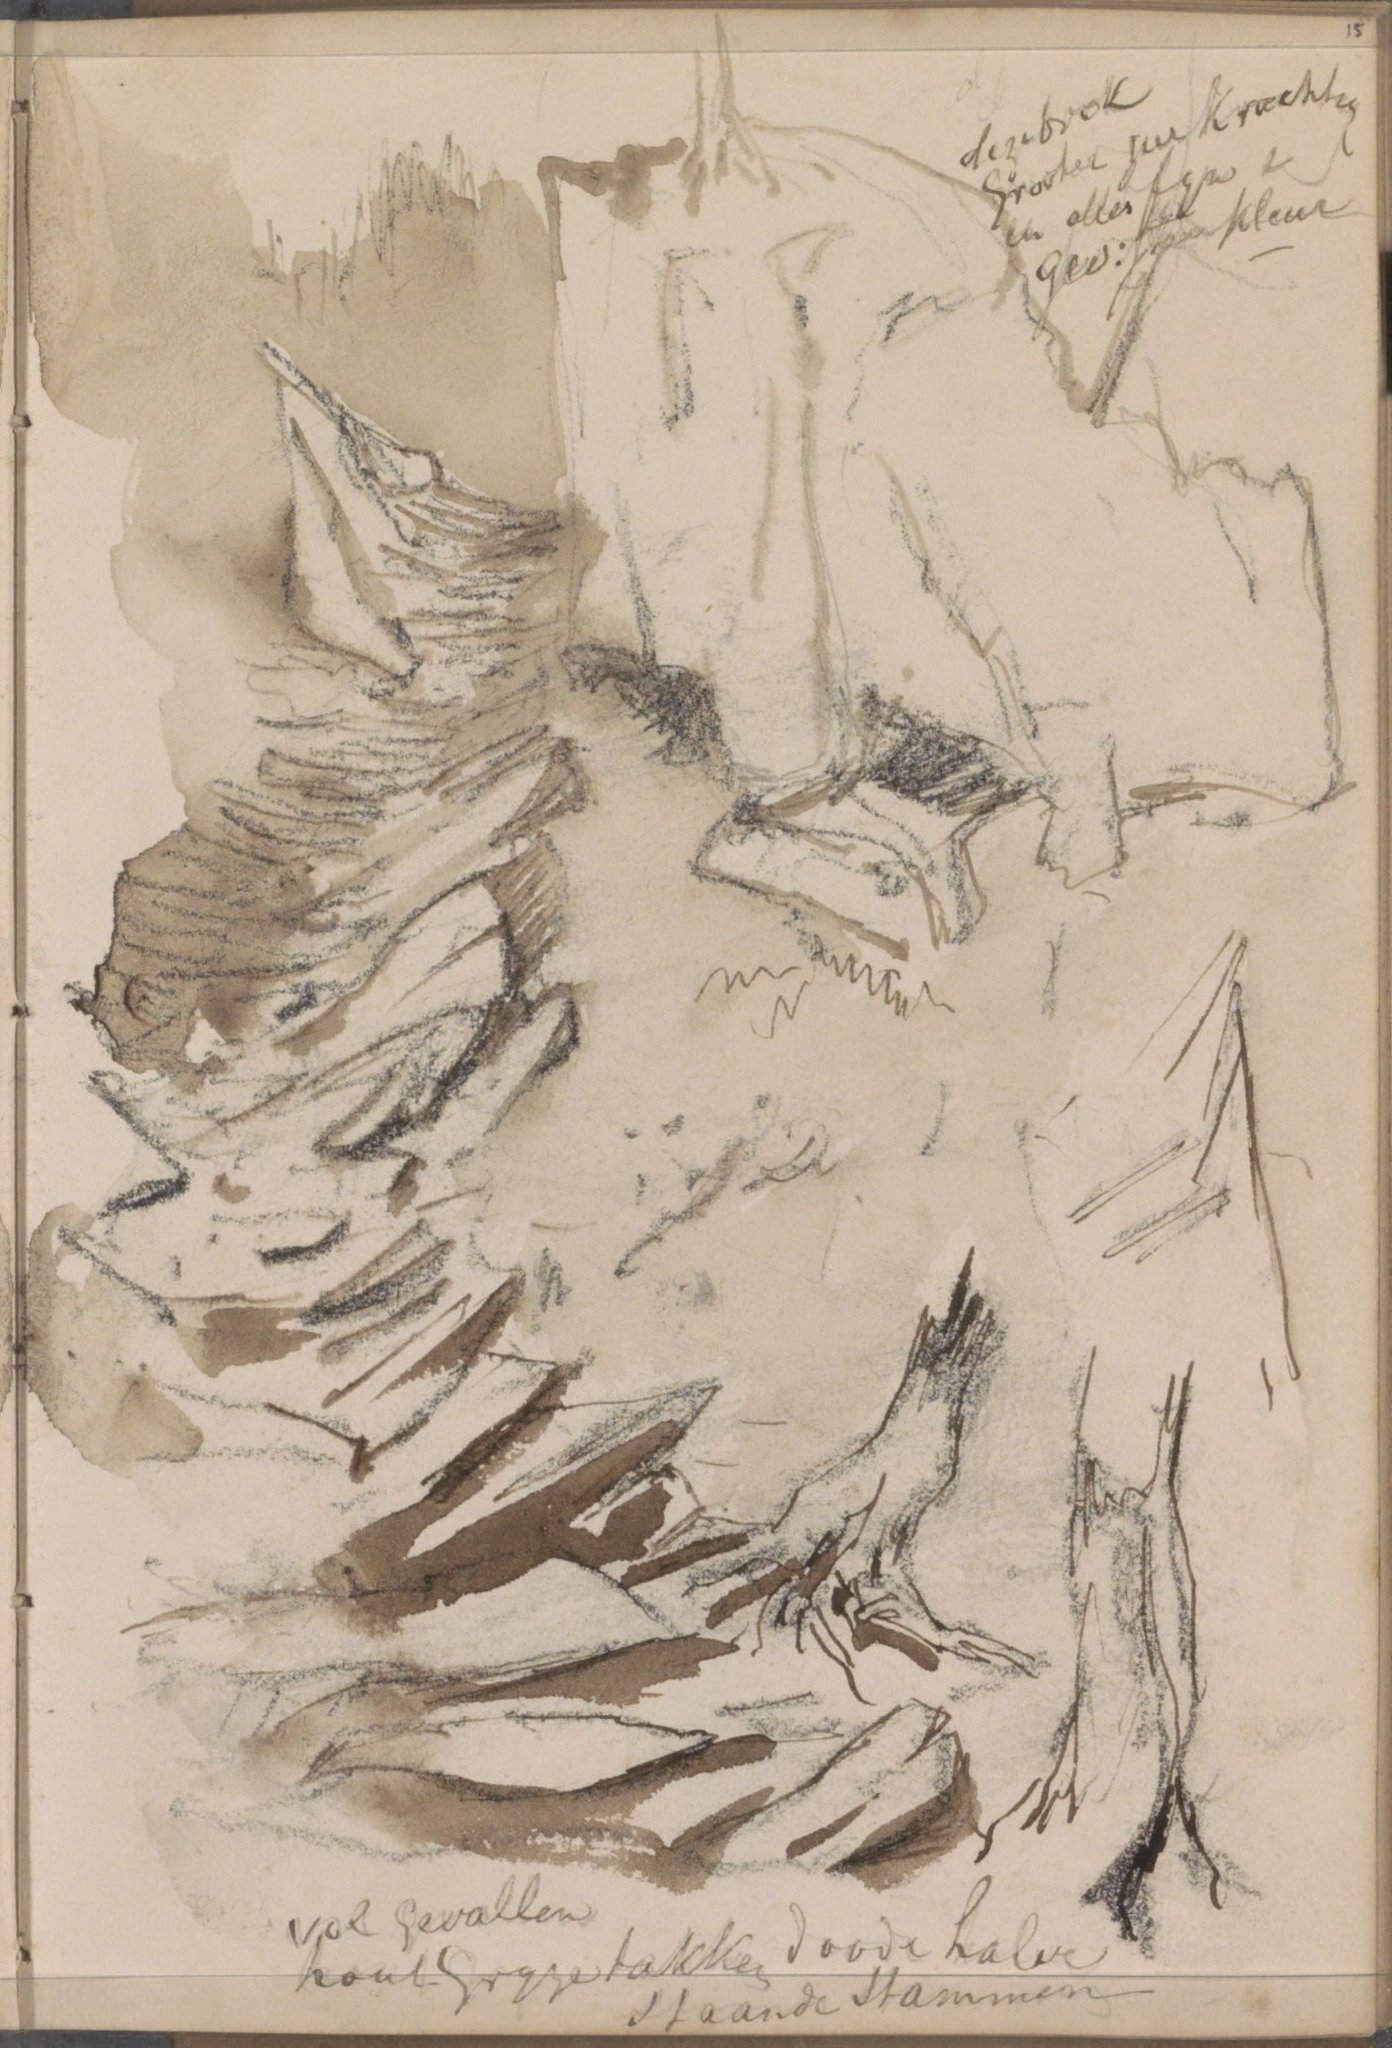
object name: sketchbook leaf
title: Stenen trap tegen een rotsachtige bergwand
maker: johannes tavenraat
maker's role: draughtsman, painter, print maker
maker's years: 1809-1881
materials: ink, paper, pencil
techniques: brush, pen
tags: trees, flight of steps, rocks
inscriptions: annotation: ‘vol gevallen/ hout grijze takken doode halve/ staande stammen’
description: Langs de trap staan dode halve boomstammen. Blad 15 recto uit een schetsboek met 47 bladen.